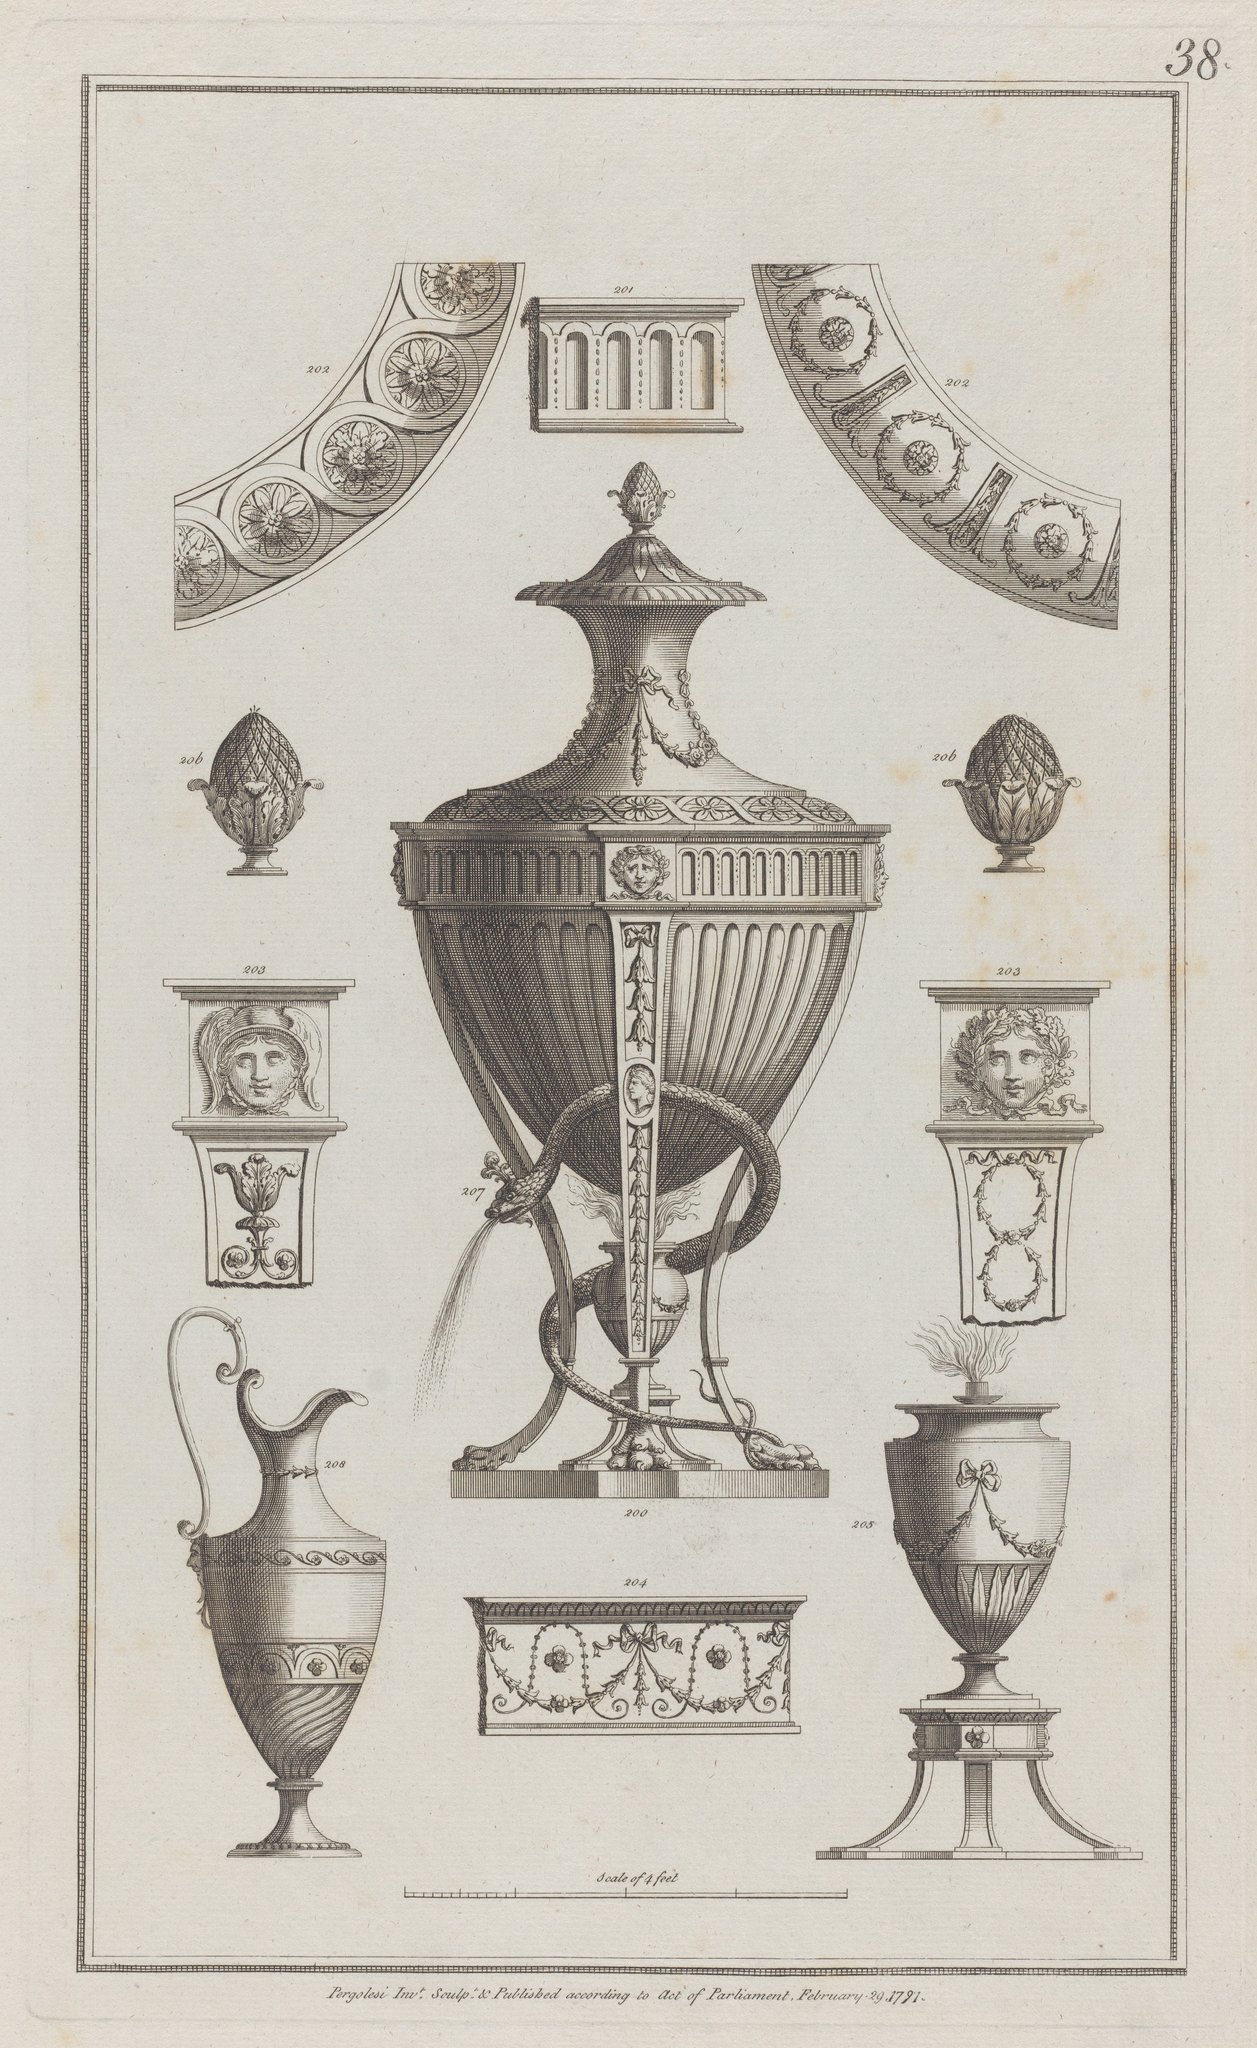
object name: print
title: Vases and Ornament Designs, nos. 200-208, plate 38 from "Designs for Various Ornaments"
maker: michelangelo pergolesi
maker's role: artist and publisher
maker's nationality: italian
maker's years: 1760-1801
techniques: etching